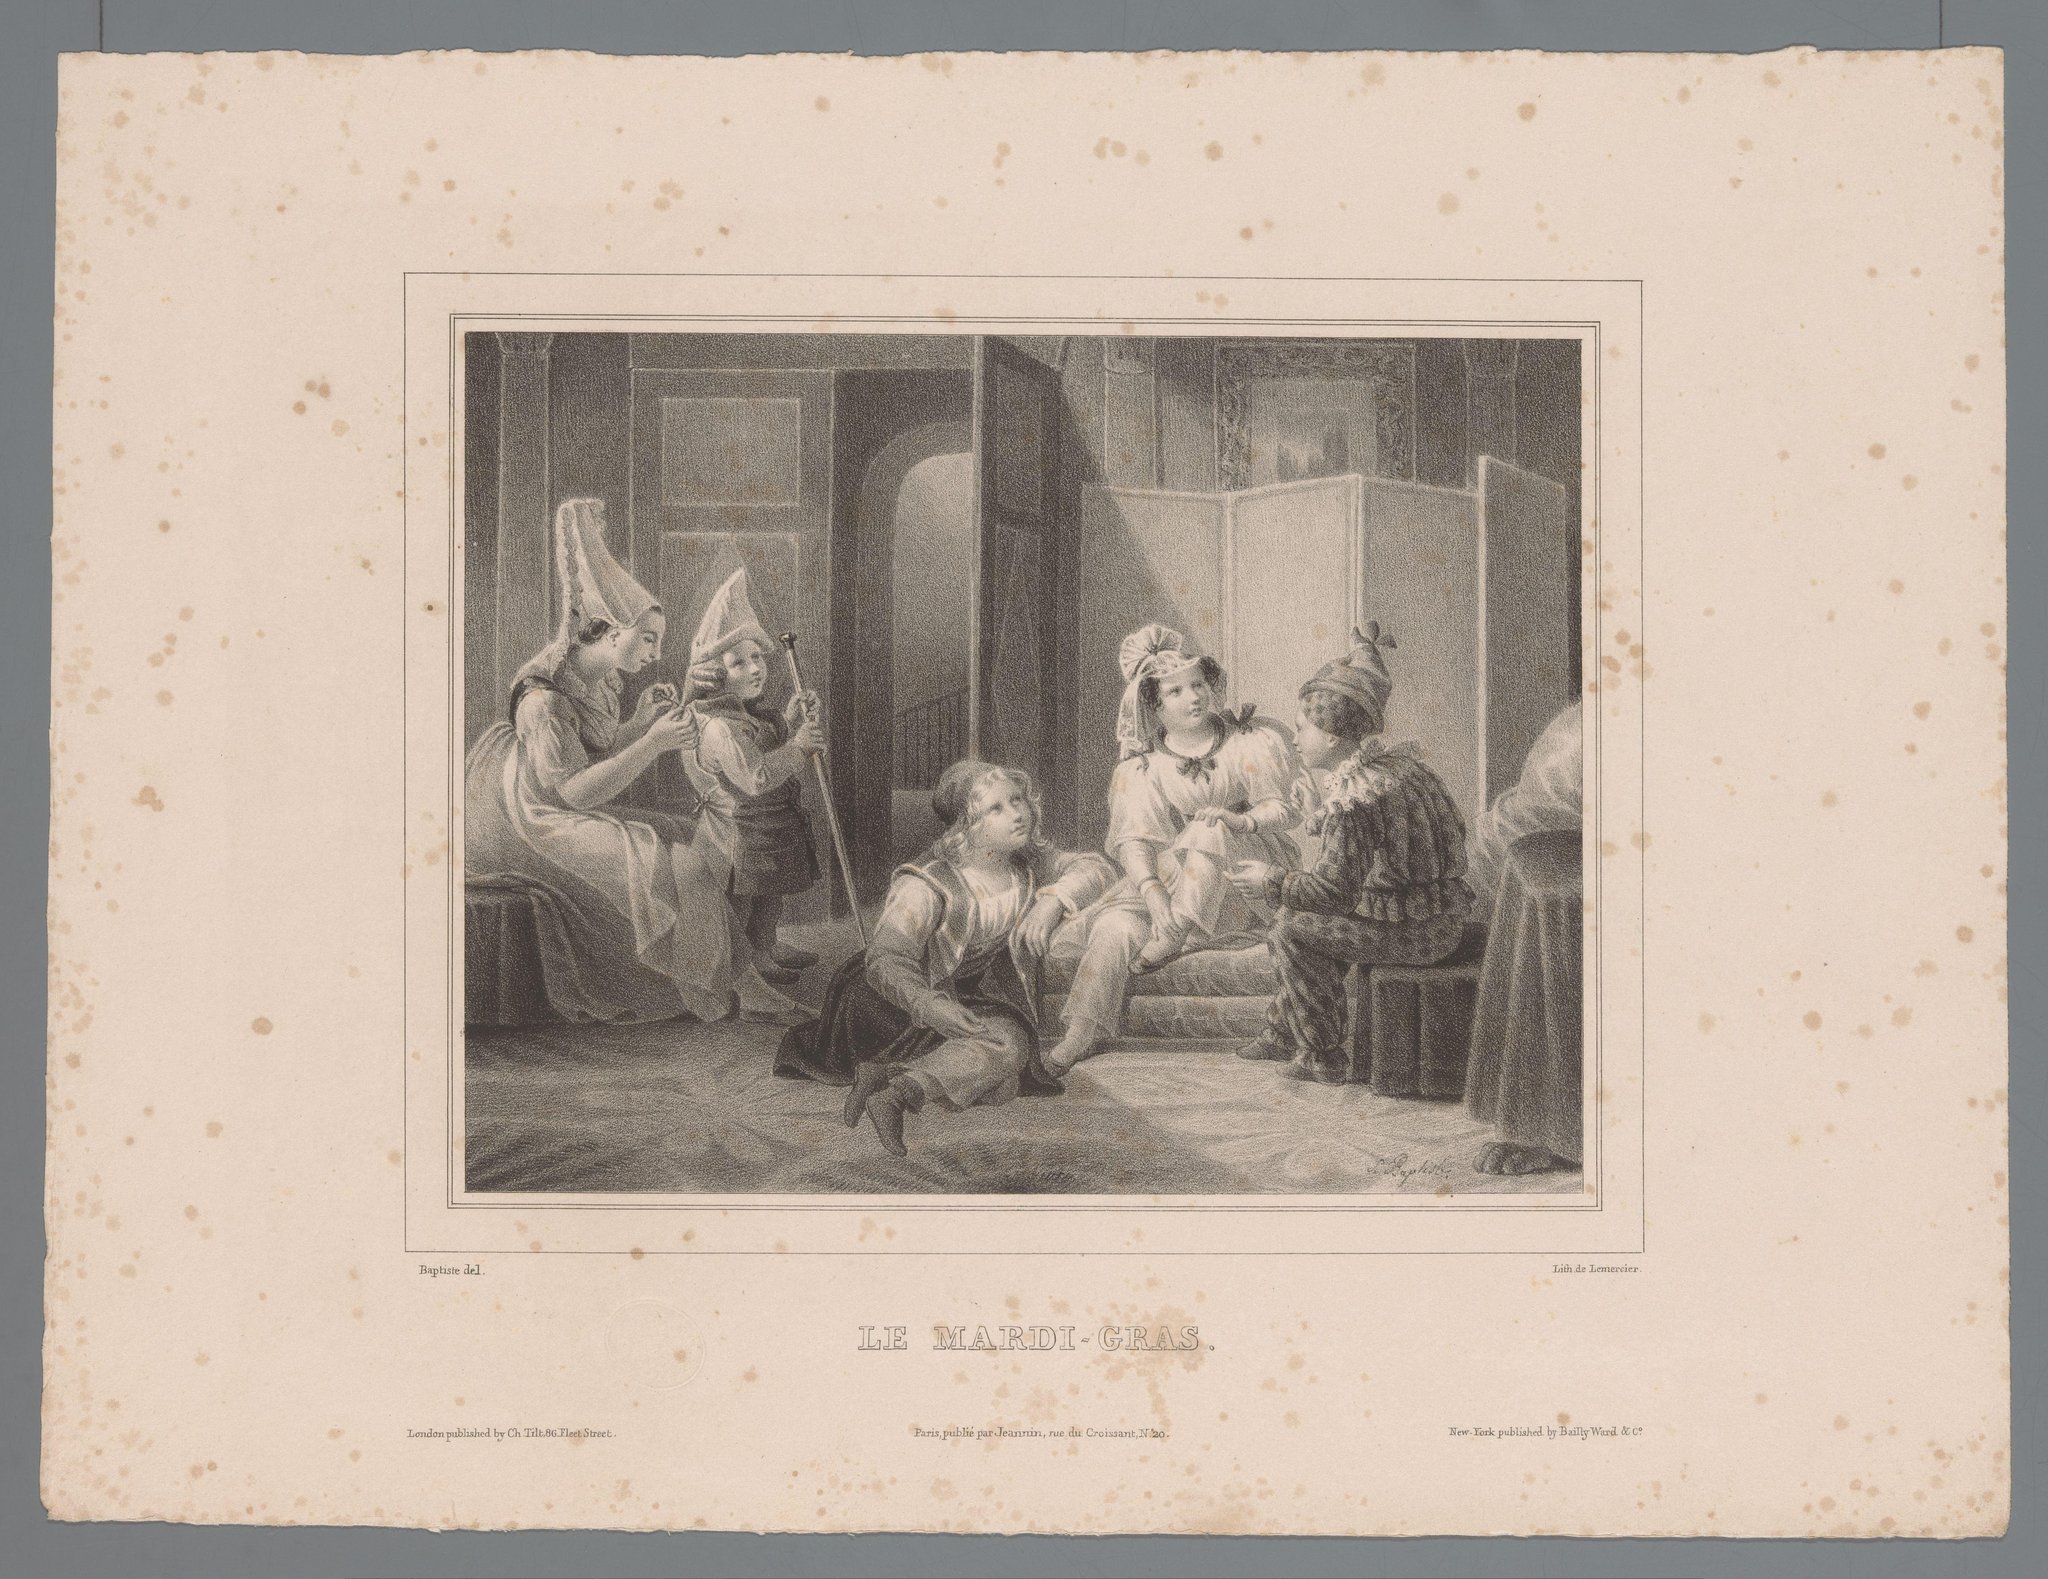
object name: print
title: Taferelen uit het dagelijks leven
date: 1833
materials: paper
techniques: lithography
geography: london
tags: children's games and plays, shrove tuesday, 'mardi gras' ~ non-liturgical celebrations of carnival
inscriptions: check stamp: Lugt 3987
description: Deze prent maakt deel uit van een omslag met zes prenten.